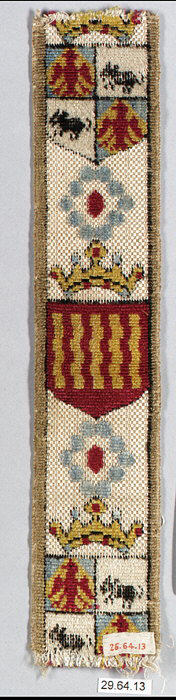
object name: galloon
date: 1701-1900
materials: silk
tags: coat of arms